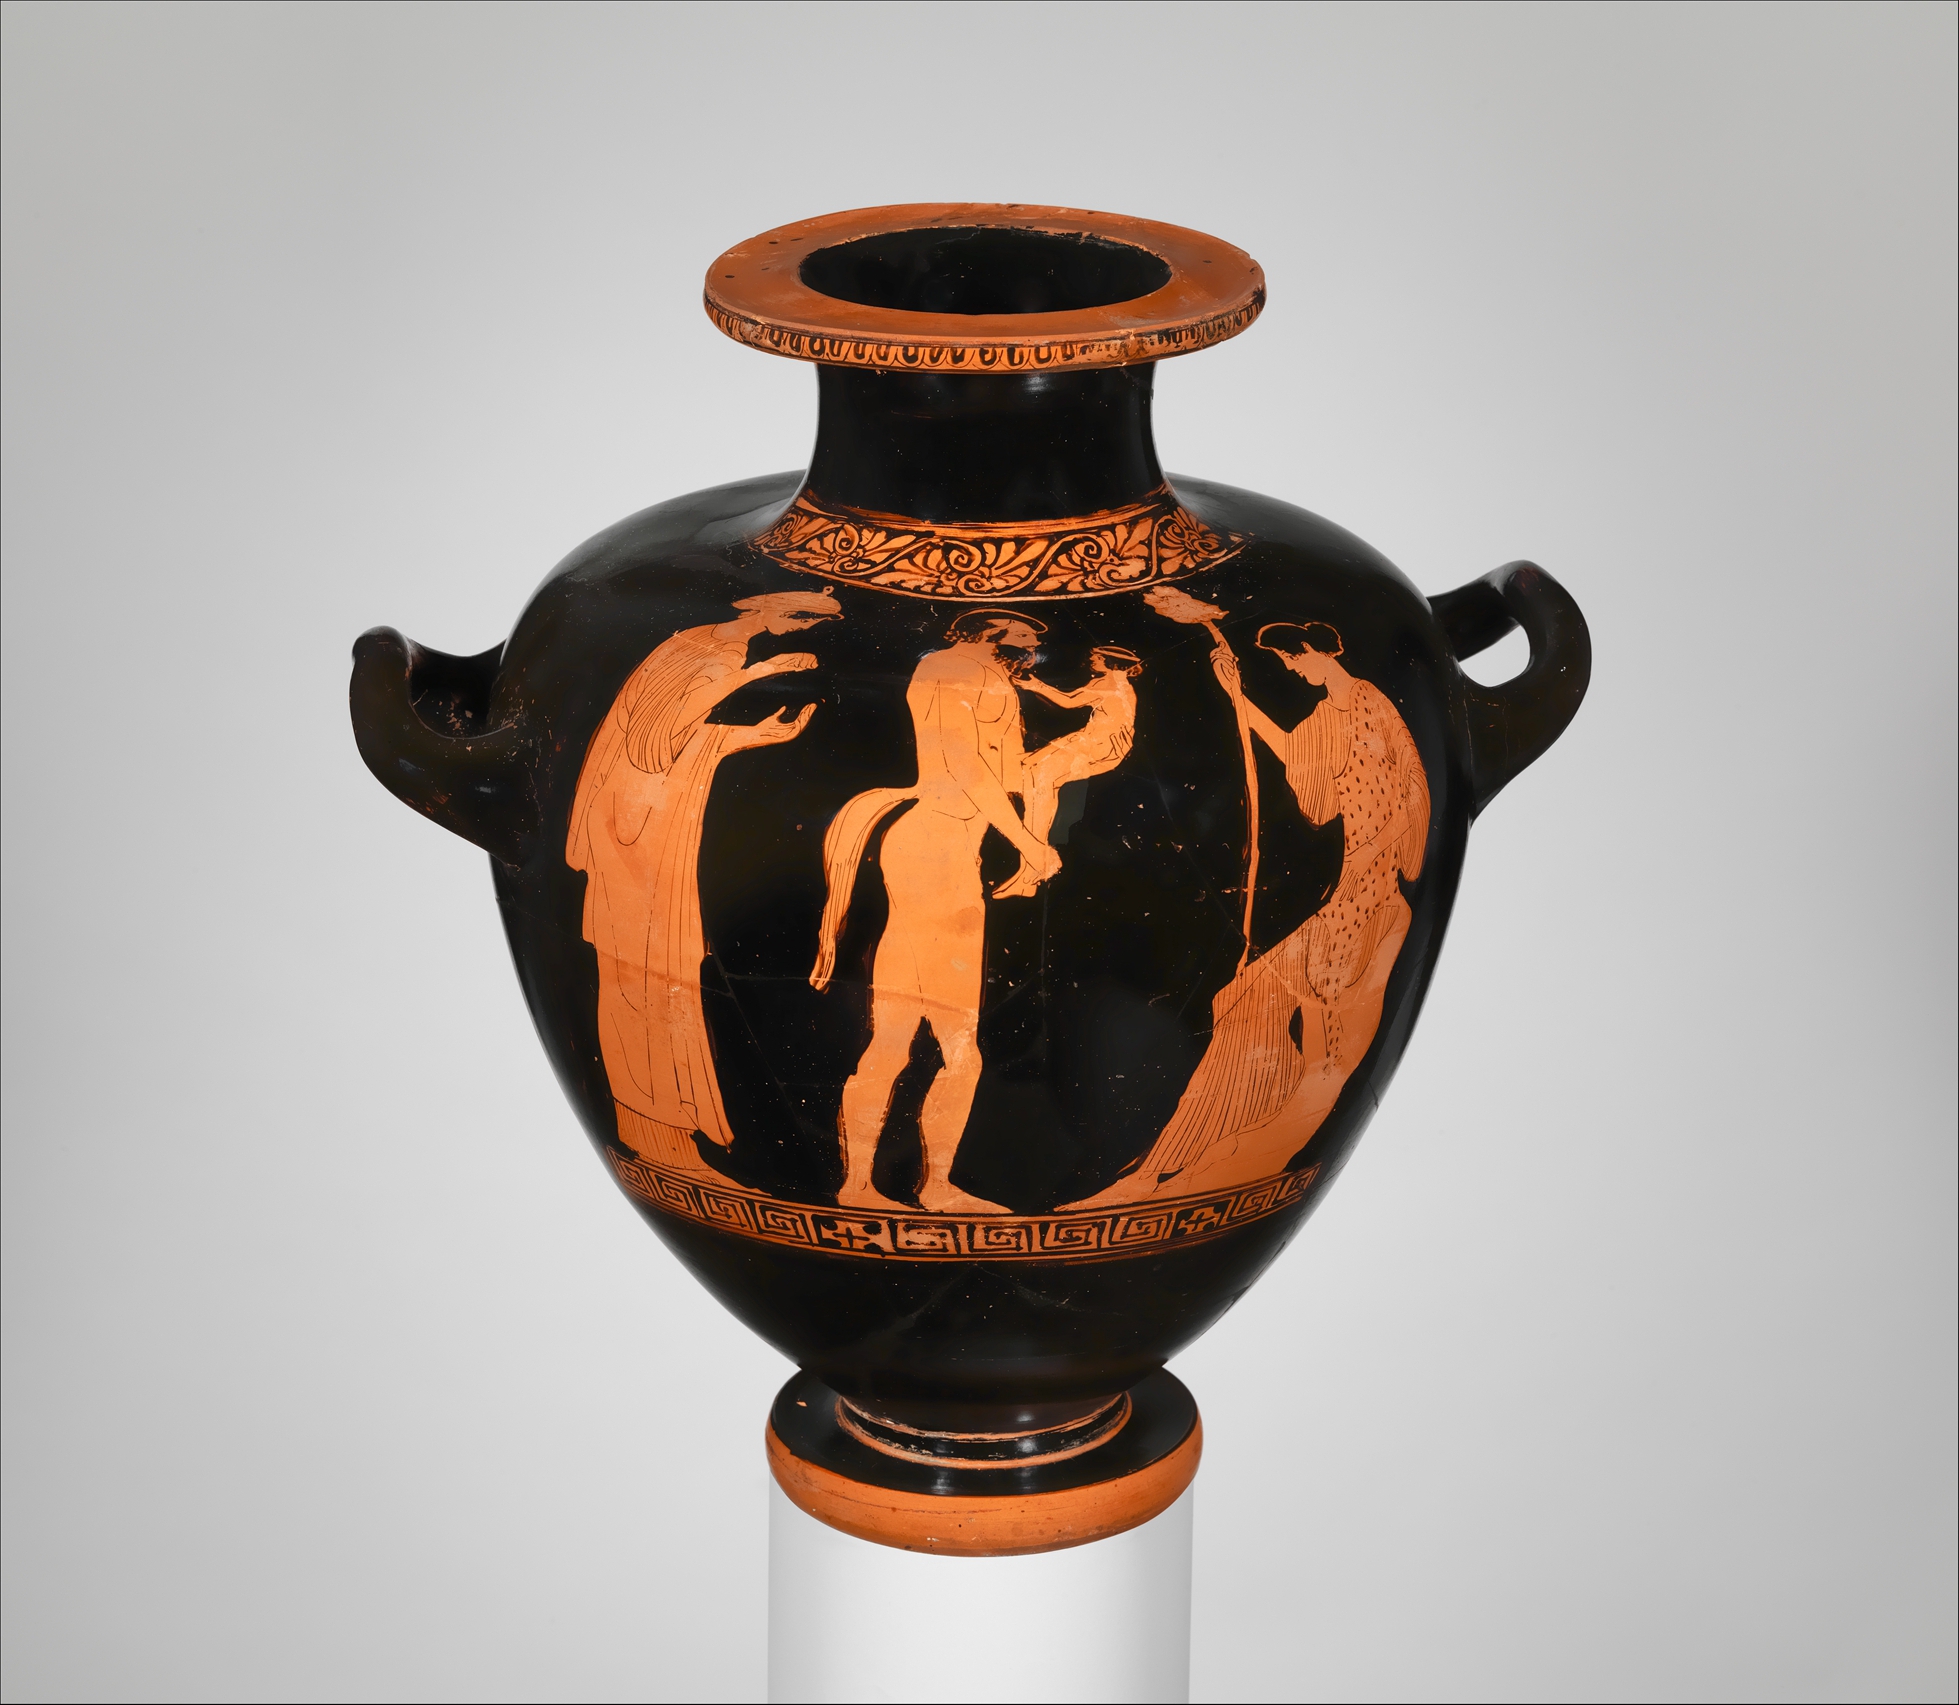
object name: hydria, kalpis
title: Terracotta hydria: kalpis (water jar)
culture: greek, attic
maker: villa giulia painter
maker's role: artist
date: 460-450 BCE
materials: terracotta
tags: dionysus,maenads,satyrs